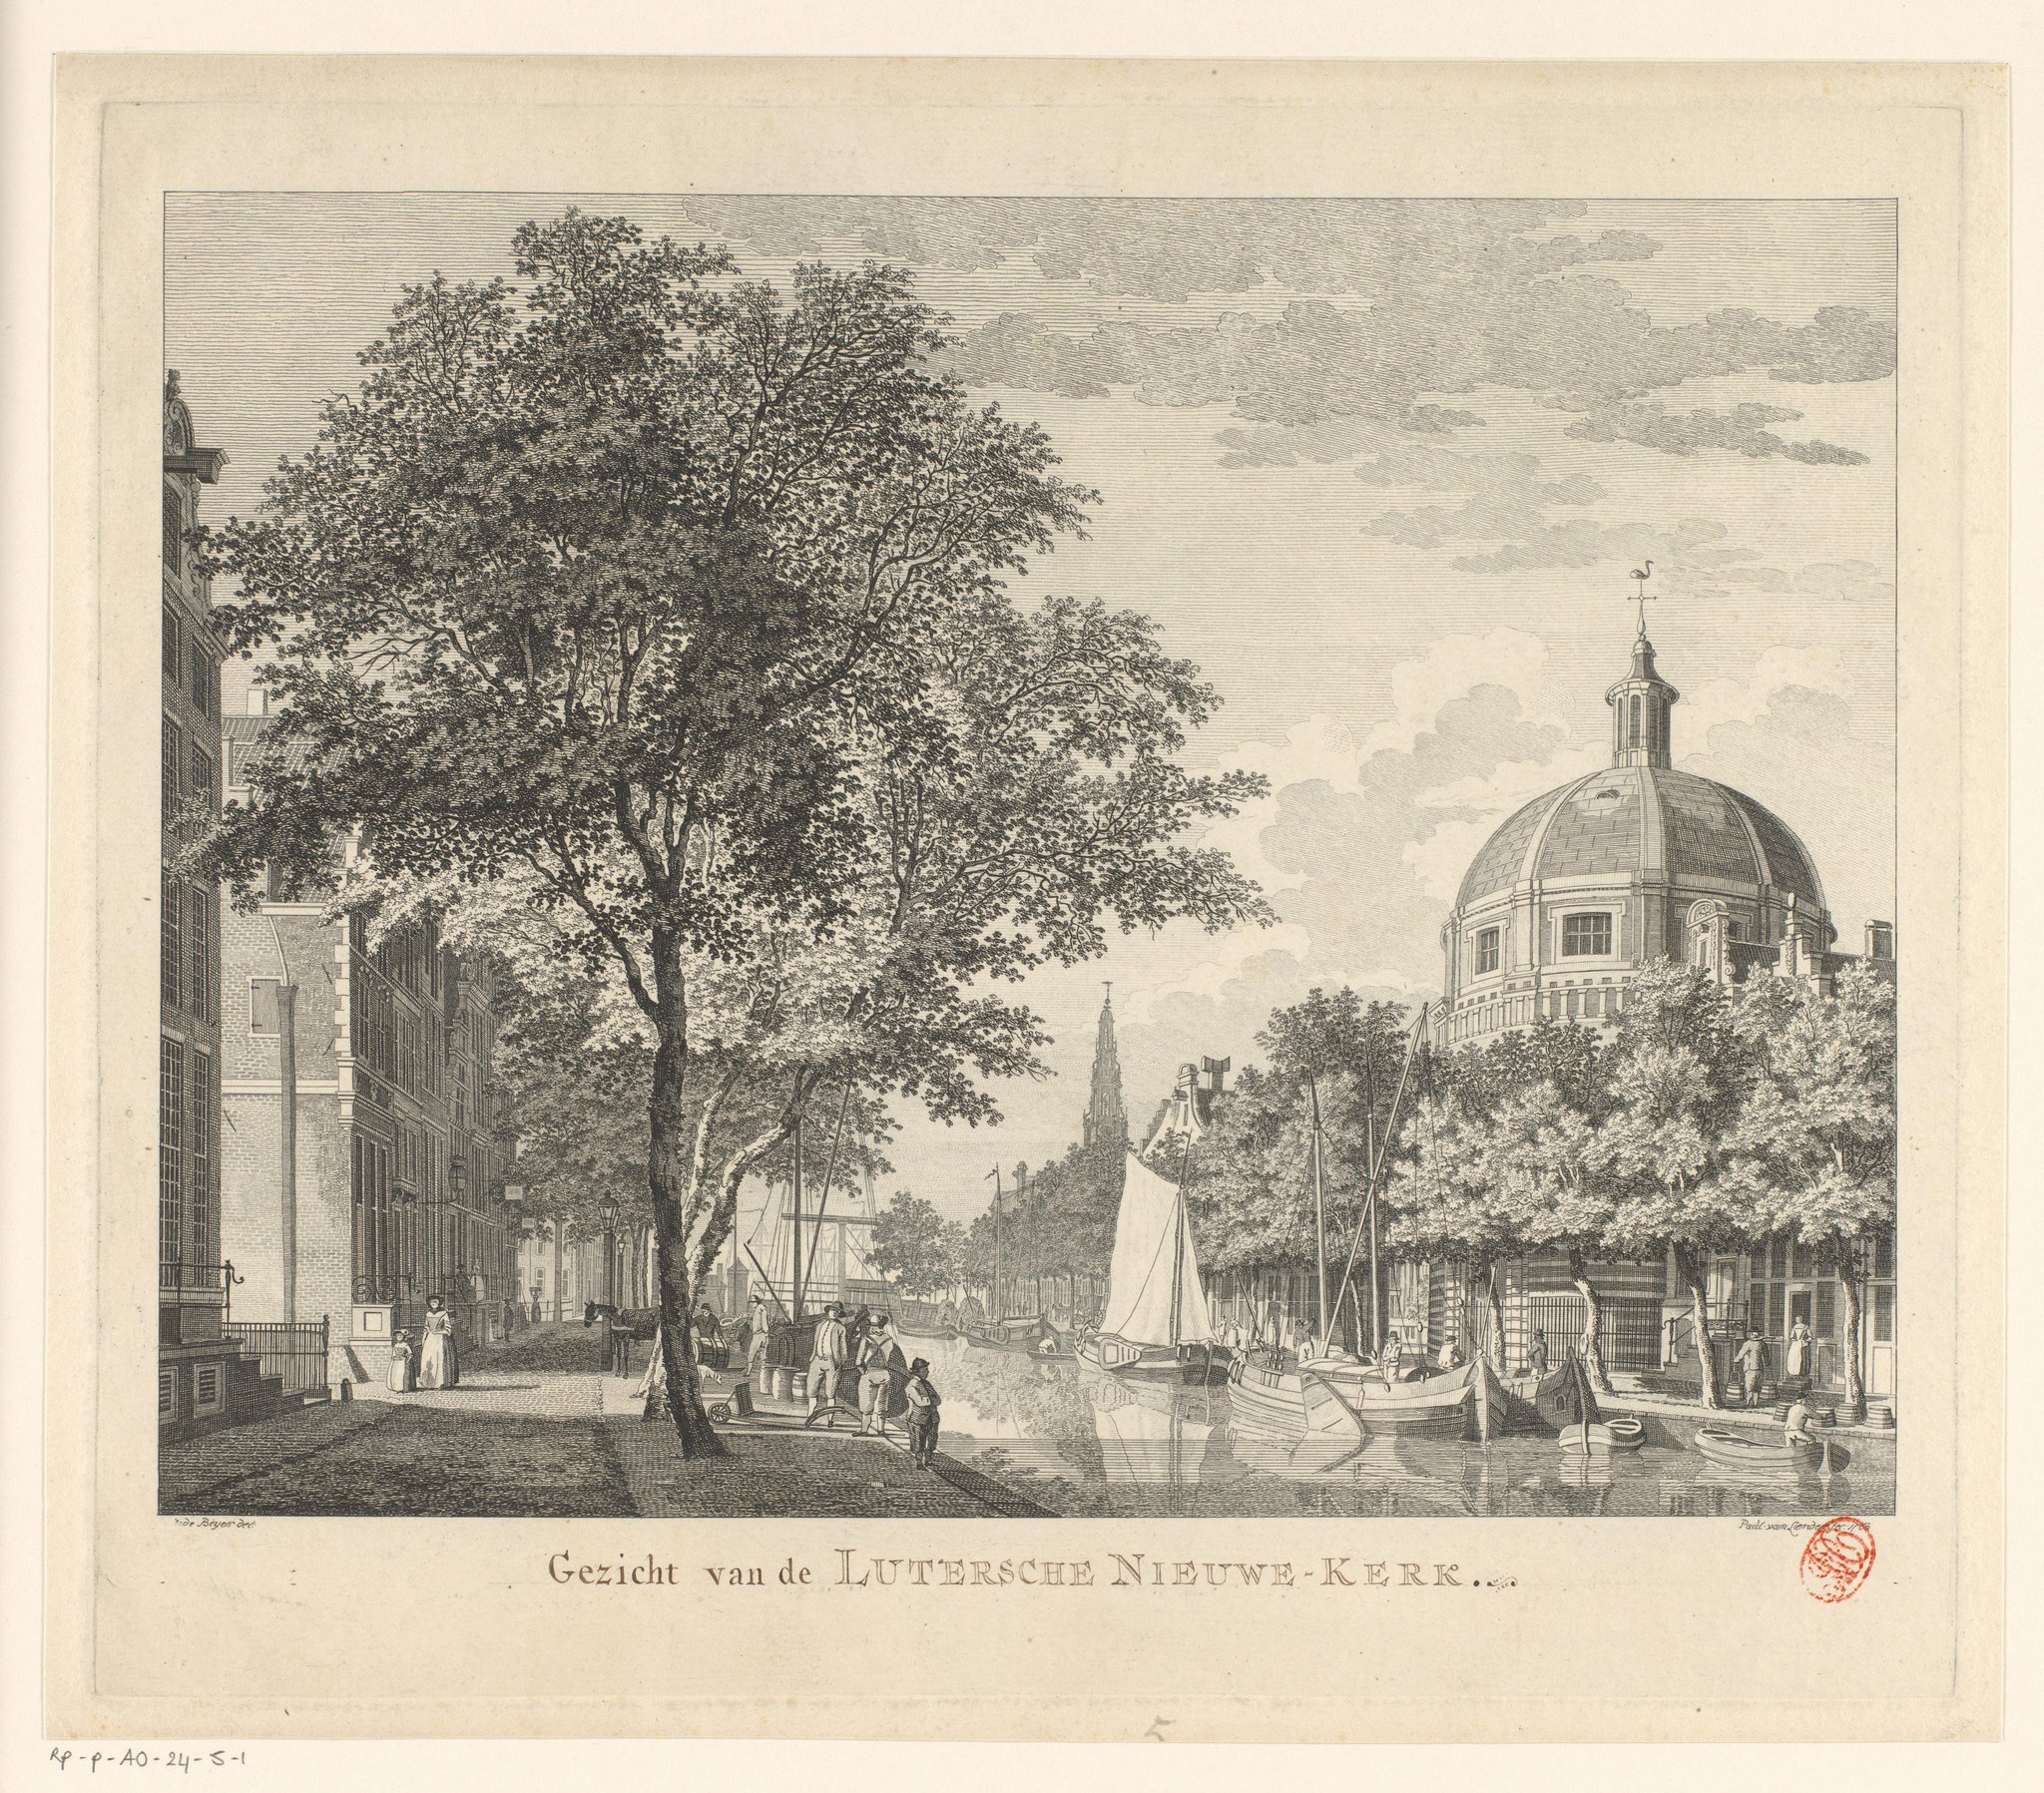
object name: print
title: Gezicht op de Ronde Lutherse Kerk te Amsterdam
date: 1760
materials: ink, paper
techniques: etching, pen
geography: amsterdam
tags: protestant churches and denominations (lutherans), towers ~ fortified city, church (exterior), canals, waters (in city) (+ city(-scape) with figures, staffage), street (+ city(-scape) with figures, staffage)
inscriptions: collector's mark: Lugt 2233, inscription: ‘Gezicht van de Lutersche Nieuwe-Kerk’, collector's mark: Lugt 195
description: Latere staten van deze prent zijn ook gebruikt in de zogenaamde Atlas van Fouquet.* Pierre Fouquet gaf vanaf 1760 stadsgezichten van Amsterdam - naar tekeningen van verschillende kunstenaars, gemaakt door verschillende prentmakers - uit. Deze prenten werden aanvankelijk los of in series verkocht. Zoals toen gebruikelijk kon de koper de prenten zelf laten inbinden. Hiertoe gaf Fouquet tussen 1778 en 1783 een titelblad, plattegrond en inhoudsopgave van de tot dusver 100 uitgegeven prenten uit (1). Gezien de inhoud afhankelijk was van wat de koper had verzameld verschilt de inhoud van de verschillende bewaarde Fouquetatlassen onder deze titel sterk. Ook zijn er exemplaren bekend waar tevens andere prenten aan zijn toegevoegd. Omdat er behoefte bleek aan uitleg bij de platen werd in 1783 een nieuwe versie van de atlas uitgegeven, aangevuld met tekst en twee prenten. De aangegeven volgorde veranderde maar de platen van de al eerder uitgegeven prenten bleven ongewijzigd. Deze uitgave werd in opdracht van Fouquet gedrukt bij Daniël Jean Changuion en Petrus den Hengst (2). Een tiental platen werd bijgewerkt en verscheen, met nieuw impressum, in het vervolg van Wagenaars geschiedenis van Amsterdam, uitgeven door Petrus Conradi en Folkert van der Plaats (3). Een aantal jaar na het overlijden van Fouquet kwam Evert Maaskamp met een nieuwe uitgave van de atlas, met verbeterde tekst en toevoeging van twee prenten. Op alle platen verwijderde hij het oude en liet hij zijn eigen impressum zetten (4). * Onder de Atlas van Fouquet of Fouquetatlas verstaan we de hieronder vermelde publicaties (1), (2) en (4). (1). Afbeeldingen van de wyd-vermaarde koopstad Amsterdam benevens des zelvs voornaamste gebouwen en gezigten alle naar het leeven getekend / Receuil des edifices les plus considerables et des plus belles vues, de la fameuse ville d'Amsterdam, dessinées d'après nature. Amsterdam: Pierre Fouquet, 1778-1783. (2). Nieuwe atlas, van de voornaamste gebouwen en gezigten der stad Amsterdam, met derzelver beknopte beschryvingen. 2 delen. Amsterdam: Daniël Jean Changuion en Petrus den Hengst [in opdracht van Pierre Fouquet], 1783. (3). Stijl, Simon. Amsterdam, in zyne geschiedenissen, voorregten, koophandel, gebouwen, kerkenstaat, schoolen, schutterye, gilden en regeeringe, beschreeven. Om te dienen ten vervolge op het werk van Jan Wagenaar (…). 10 delen. Amsterdam en Harlingen: Petrus Conradi en Folkert van der Plaats, 1788-1801. (4). Nieuwe atlas, van de voornaamste gebouwen en gezigten der stad Amsterdam. Met derzelver beknopte beschryvingen. Amsterdam: Evert Maaskamp, 1805. * Het aantal vermelde staten is gebaseerd op het aantal gevonden staten. Mogelijk zijn er meer staten van deze prent. Voor derde bekende staat zie RP-P-AO-24-5-2. Voor vierde bekende staat zie RP-P-OB-46.352.